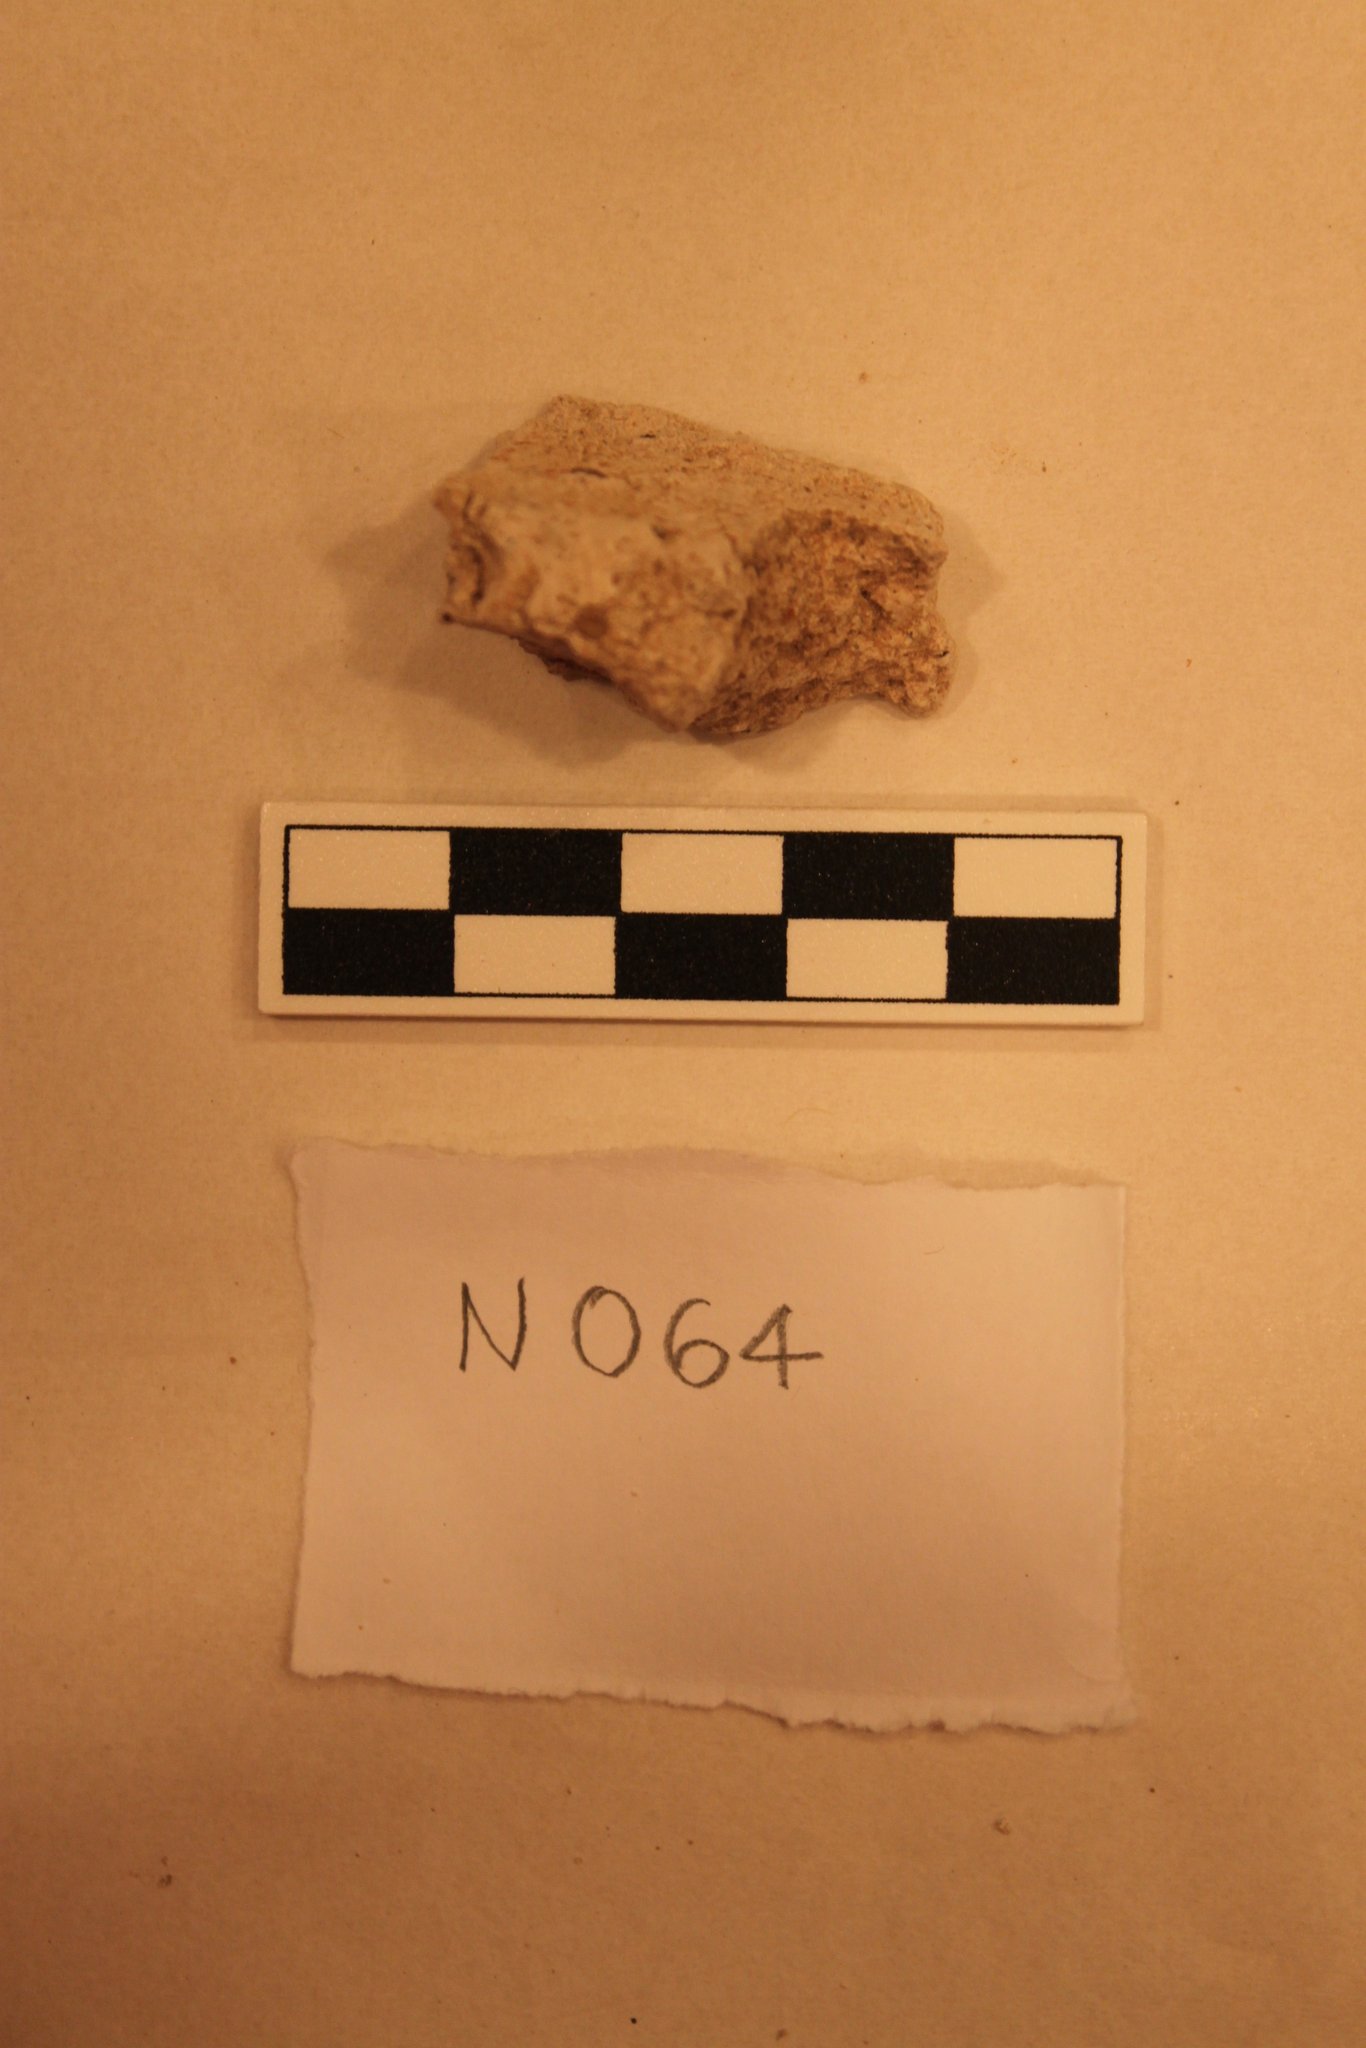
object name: fragment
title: Stucco Fragment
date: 701-1200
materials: plaster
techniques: carving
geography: iran